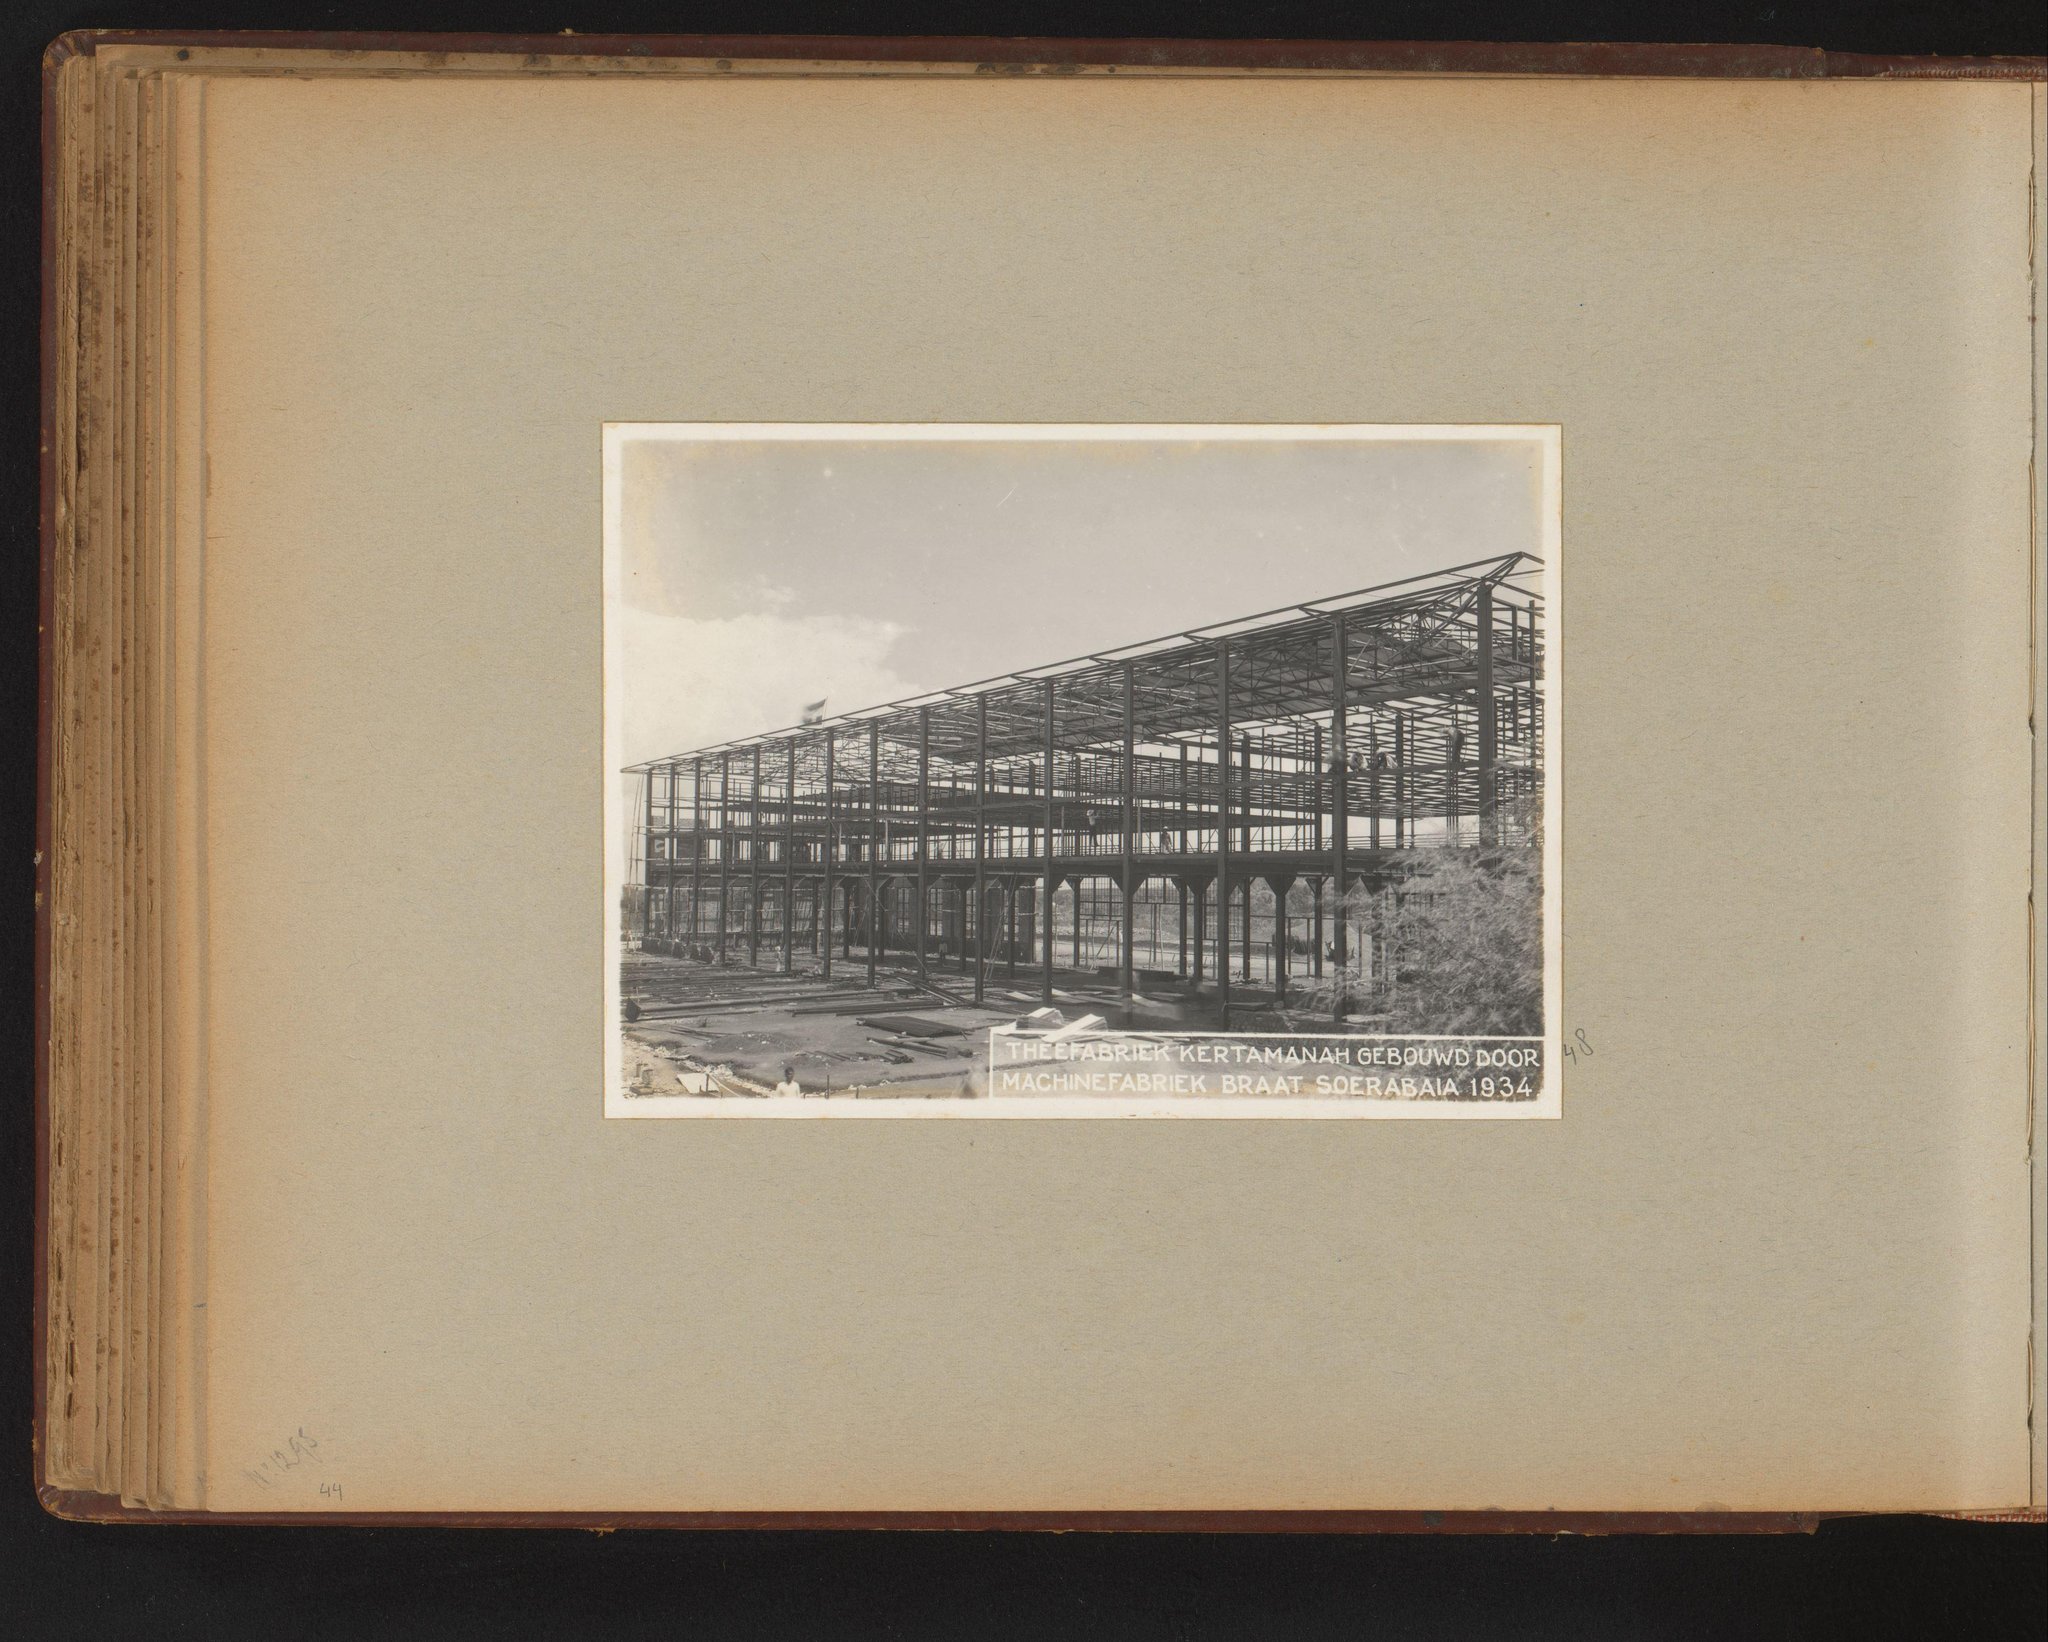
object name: album leaf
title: Theefabriek Kertamanah gebouwd door Machinefabriek Braat Soerabaia 1934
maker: Anonymous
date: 1934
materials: cardboard, photographic support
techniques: gelatin silver print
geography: bandung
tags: factory-building, making the overground structures (~ building activities), java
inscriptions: date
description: Albumblad met een foto van de theefabriek Kertamanah ten zuiden van Bandoeng, in aanbouw in 1934. Onderdeel van een fotoalbum met foto's van machines en constructies van de N.V. Machinefabriek Braat te Soerabaja, Soekaboemi en Tegal uit de periode 1931-1937.